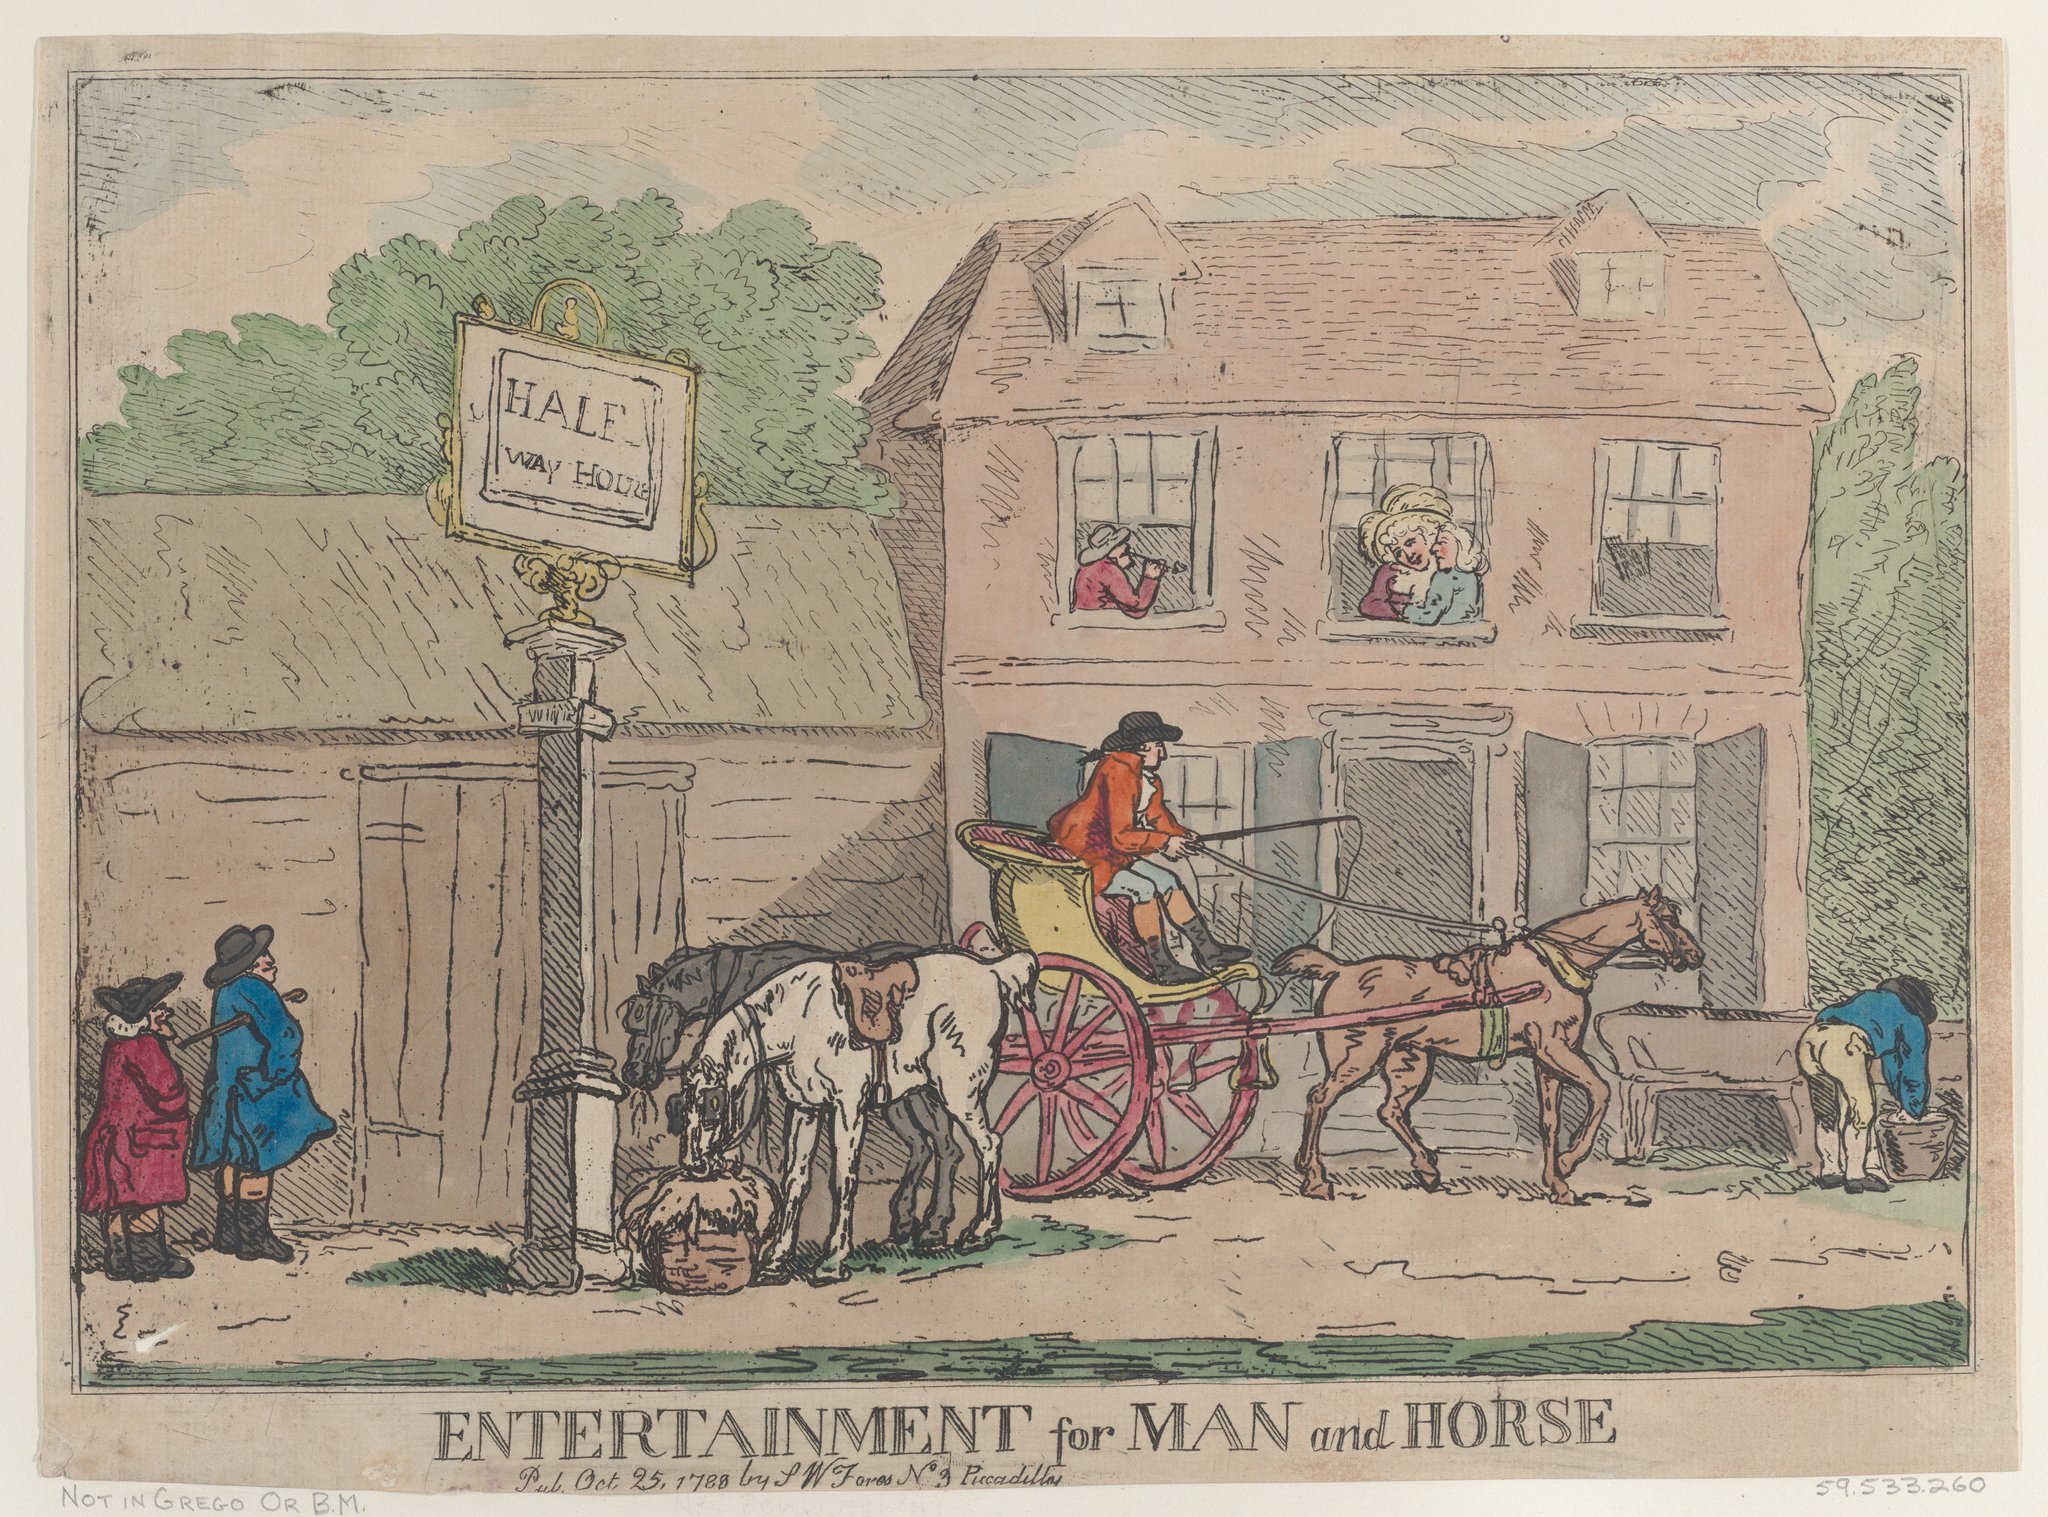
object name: print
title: Entertainment for Man and Horse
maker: thomas rowlandson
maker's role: artist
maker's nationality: british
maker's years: 1757-1827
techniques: etching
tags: houses,horses,carriages